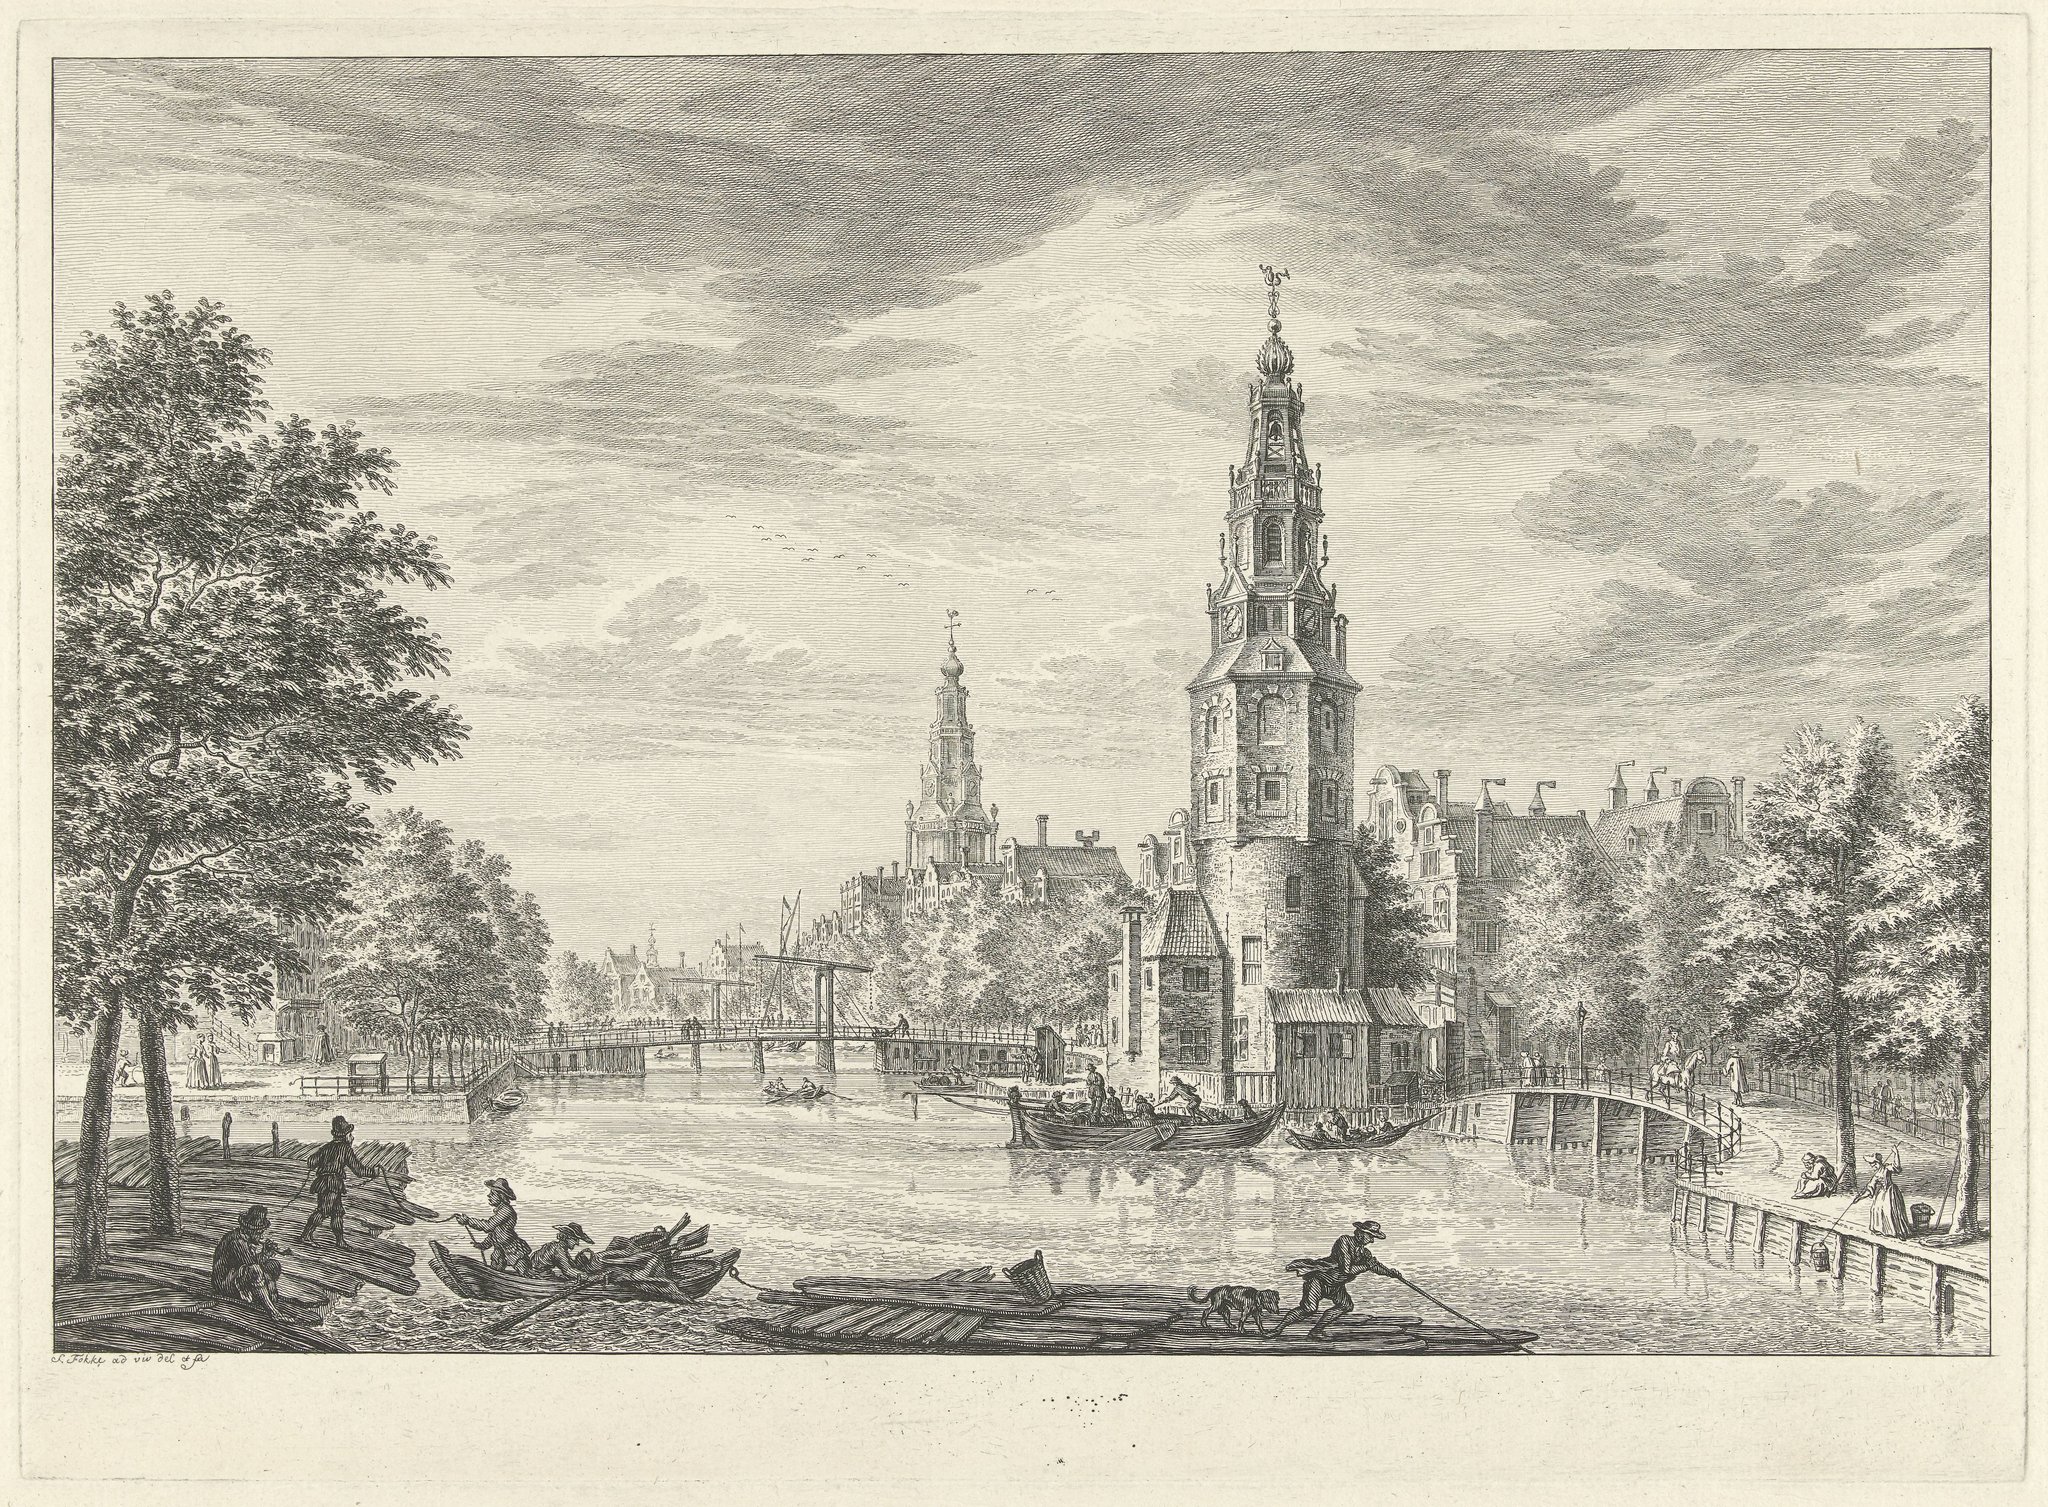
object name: print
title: Gezicht op de Montelbaanstoren te Amsterdam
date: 1760-1783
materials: paper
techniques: engraving, etching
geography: amsterdam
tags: bridge in city across river, canal, etc. (+ city(-scape) with figures, staffage), tower, clock tower ~ monumental adornment, towers ~ fortified city, canals, waters (in city) (+ city(-scape) with figures, staffage), street (+ city(-scape) with figures, staffage), parts of church exterior and annexes: tower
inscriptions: collector's mark: Lugt 2228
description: Latere staat opgenomen in: Nieuwe atlas, van de voornaamste gebouwen en gezigten der stad Amsterdam, met derzelver beknopte beschryvingen, 2 dln. Amsterdam: Daniel Jean Changuion en Petrus van Hengst, 1783.Latere staten van deze prent zijn ook gebruikt in de zogenaamde Atlas van Fouquet.* Pierre Fouquet gaf vanaf 1760 stadsgezichten van Amsterdam - naar tekeningen van verschillende kunstenaars, gemaakt door verschillende prentmakers - uit. Deze prenten werden aanvankelijk los of in series verkocht. Zoals toen gebruikelijk kon de koper de prenten zelf laten inbinden. Hiertoe gaf Fouquet tussen 1778 en 1783 een titelblad, plattegrond en inhoudsopgave van de tot dusver 100 uitgegeven prenten uit (1). Gezien de inhoud afhankelijk was van wat de koper had verzameld verschilt de inhoud van de verschillende bewaarde Fouquetatlassen onder deze titel sterk. Ook zijn er exemplaren bekend waar tevens andere prenten aan zijn toegevoegd. Omdat er behoefte bleek aan uitleg bij de platen werd in 1783 een nieuwe versie van de atlas uitgegeven, aangevuld met tekst en twee prenten. De aangegeven volgorde veranderde maar de platen van de al eerder uitgegeven prenten bleven ongewijzigd. Deze uitgave werd in opdracht van Fouquet gedrukt bij Daniël Jean Changuion en Petrus den Hengst (2). Een tiental platen werd bijgewerkt en verscheen, met nieuw impressum, in het vervolg van Wagenaars geschiedenis van Amsterdam, uitgeven door Petrus Conradi en Folkert van der Plaats (3). Een aantal jaar na het overlijden van Fouquet kwam Evert Maaskamp met een nieuwe uitgave van de atlas, met verbeterde tekst en toevoeging van twee prenten. Op alle platen verwijderde hij het oude en liet hij zijn eigen impressum zetten (4). * Onder de Atlas van Fouquet of Fouquetatlas verstaan we de hieronder vermelde publicaties (1), (2) en (4). (1). Afbeeldingen van de wyd-vermaarde koopstad Amsterdam benevens des zelvs voornaamste gebouwen en gezigten alle naar het leeven getekend / Receuil des edifices les plus considerables et des plus belles vues, de la fameuse ville d'Amsterdam, dessinées d'après nature. Amsterdam: Pierre Fouquet, 1778-1783. (2). Nieuwe atlas, van de voornaamste gebouwen en gezigten der stad Amsterdam, met derzelver beknopte beschryvingen. 2 delen. Amsterdam: Daniël Jean Changuion en Petrus den Hengst [in opdracht van Pierre Fouquet], 1783. (3). Stijl, Simon. Amsterdam, in zyne geschiedenissen, voorregten, koophandel, gebouwen, kerkenstaat, schoolen, schutterye, gilden en regeeringe, beschreeven. Om te dienen ten vervolge op het werk van Jan Wagenaar (…). 10 delen. Amsterdam en Harlingen: Petrus Conradi en Folkert van der Plaats, 1788-1801. (4). Nieuwe atlas, van de voornaamste gebouwen en gezigten der stad Amsterdam. Met derzelver beknopte beschryvingen. Amsterdam: Evert Maaskamp, 1805. * Het aantal vermelde staten is gebaseerd op het aantal gevonden staten. Mogelijk zijn er meer staten van deze prent. Zie ook RP-P-AO-27-42 voor eerste bekende staat. Zie RP-P-1905-404 voor tweede bekende staat.